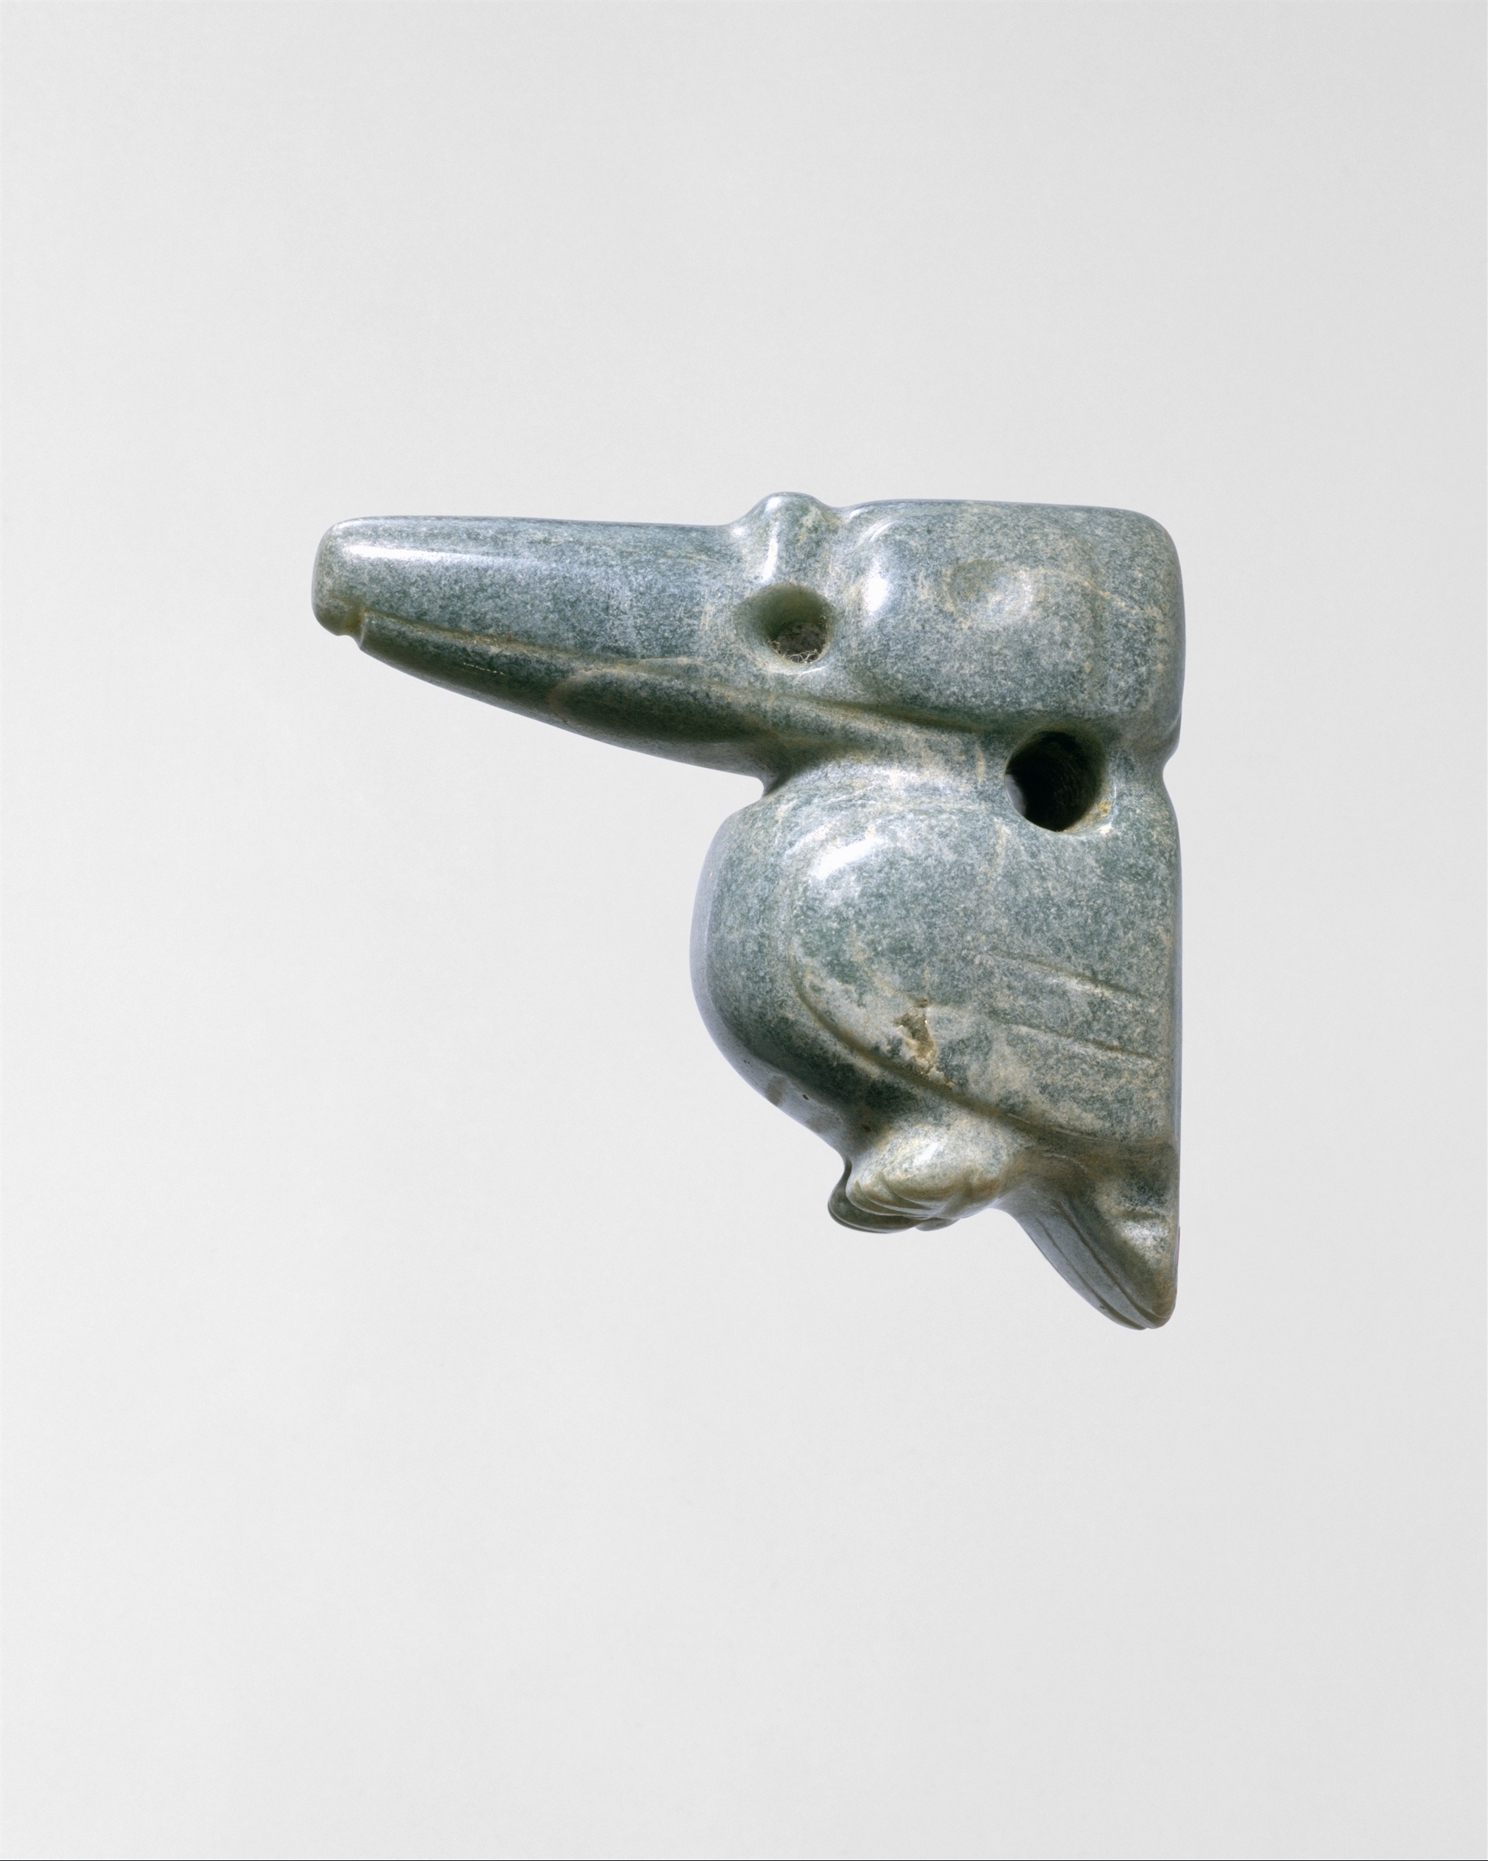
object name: pendant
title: Bird pendant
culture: guanacaste-nicoya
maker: greater nicoya or central region artitst(s)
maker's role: artist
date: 100-800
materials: jade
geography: costa rica